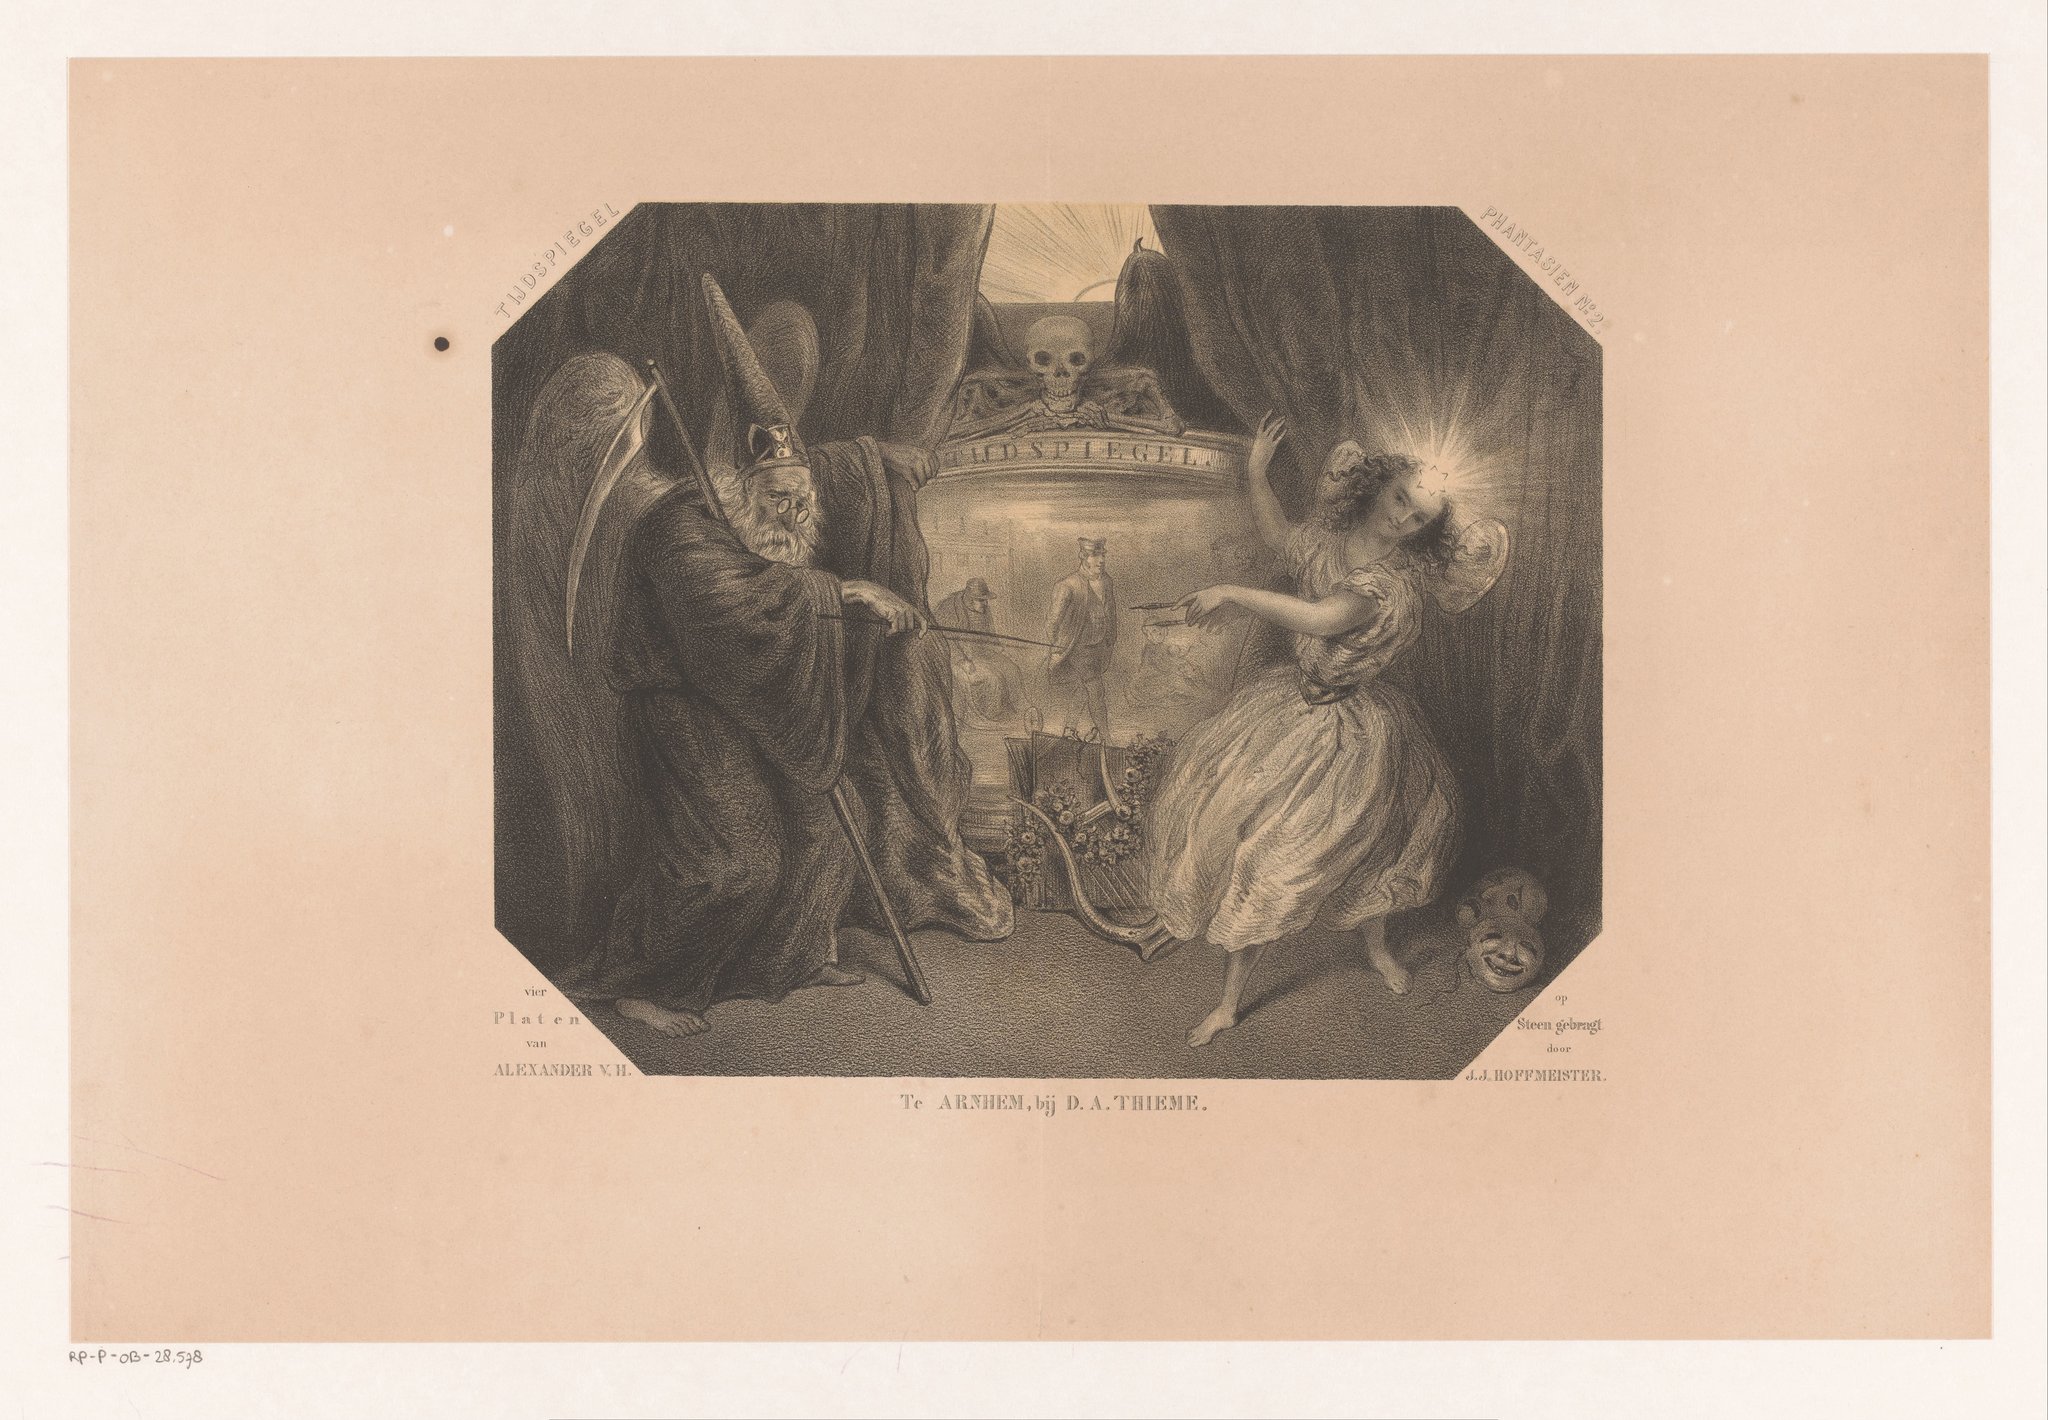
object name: print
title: Portret van dr. Jacob Christiaan Muller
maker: willem witsen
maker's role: draughtsman, painter, print maker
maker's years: 1860-1923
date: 1884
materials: paper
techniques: etching, intaglio, roulette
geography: ewijkshoeve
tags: historical persons